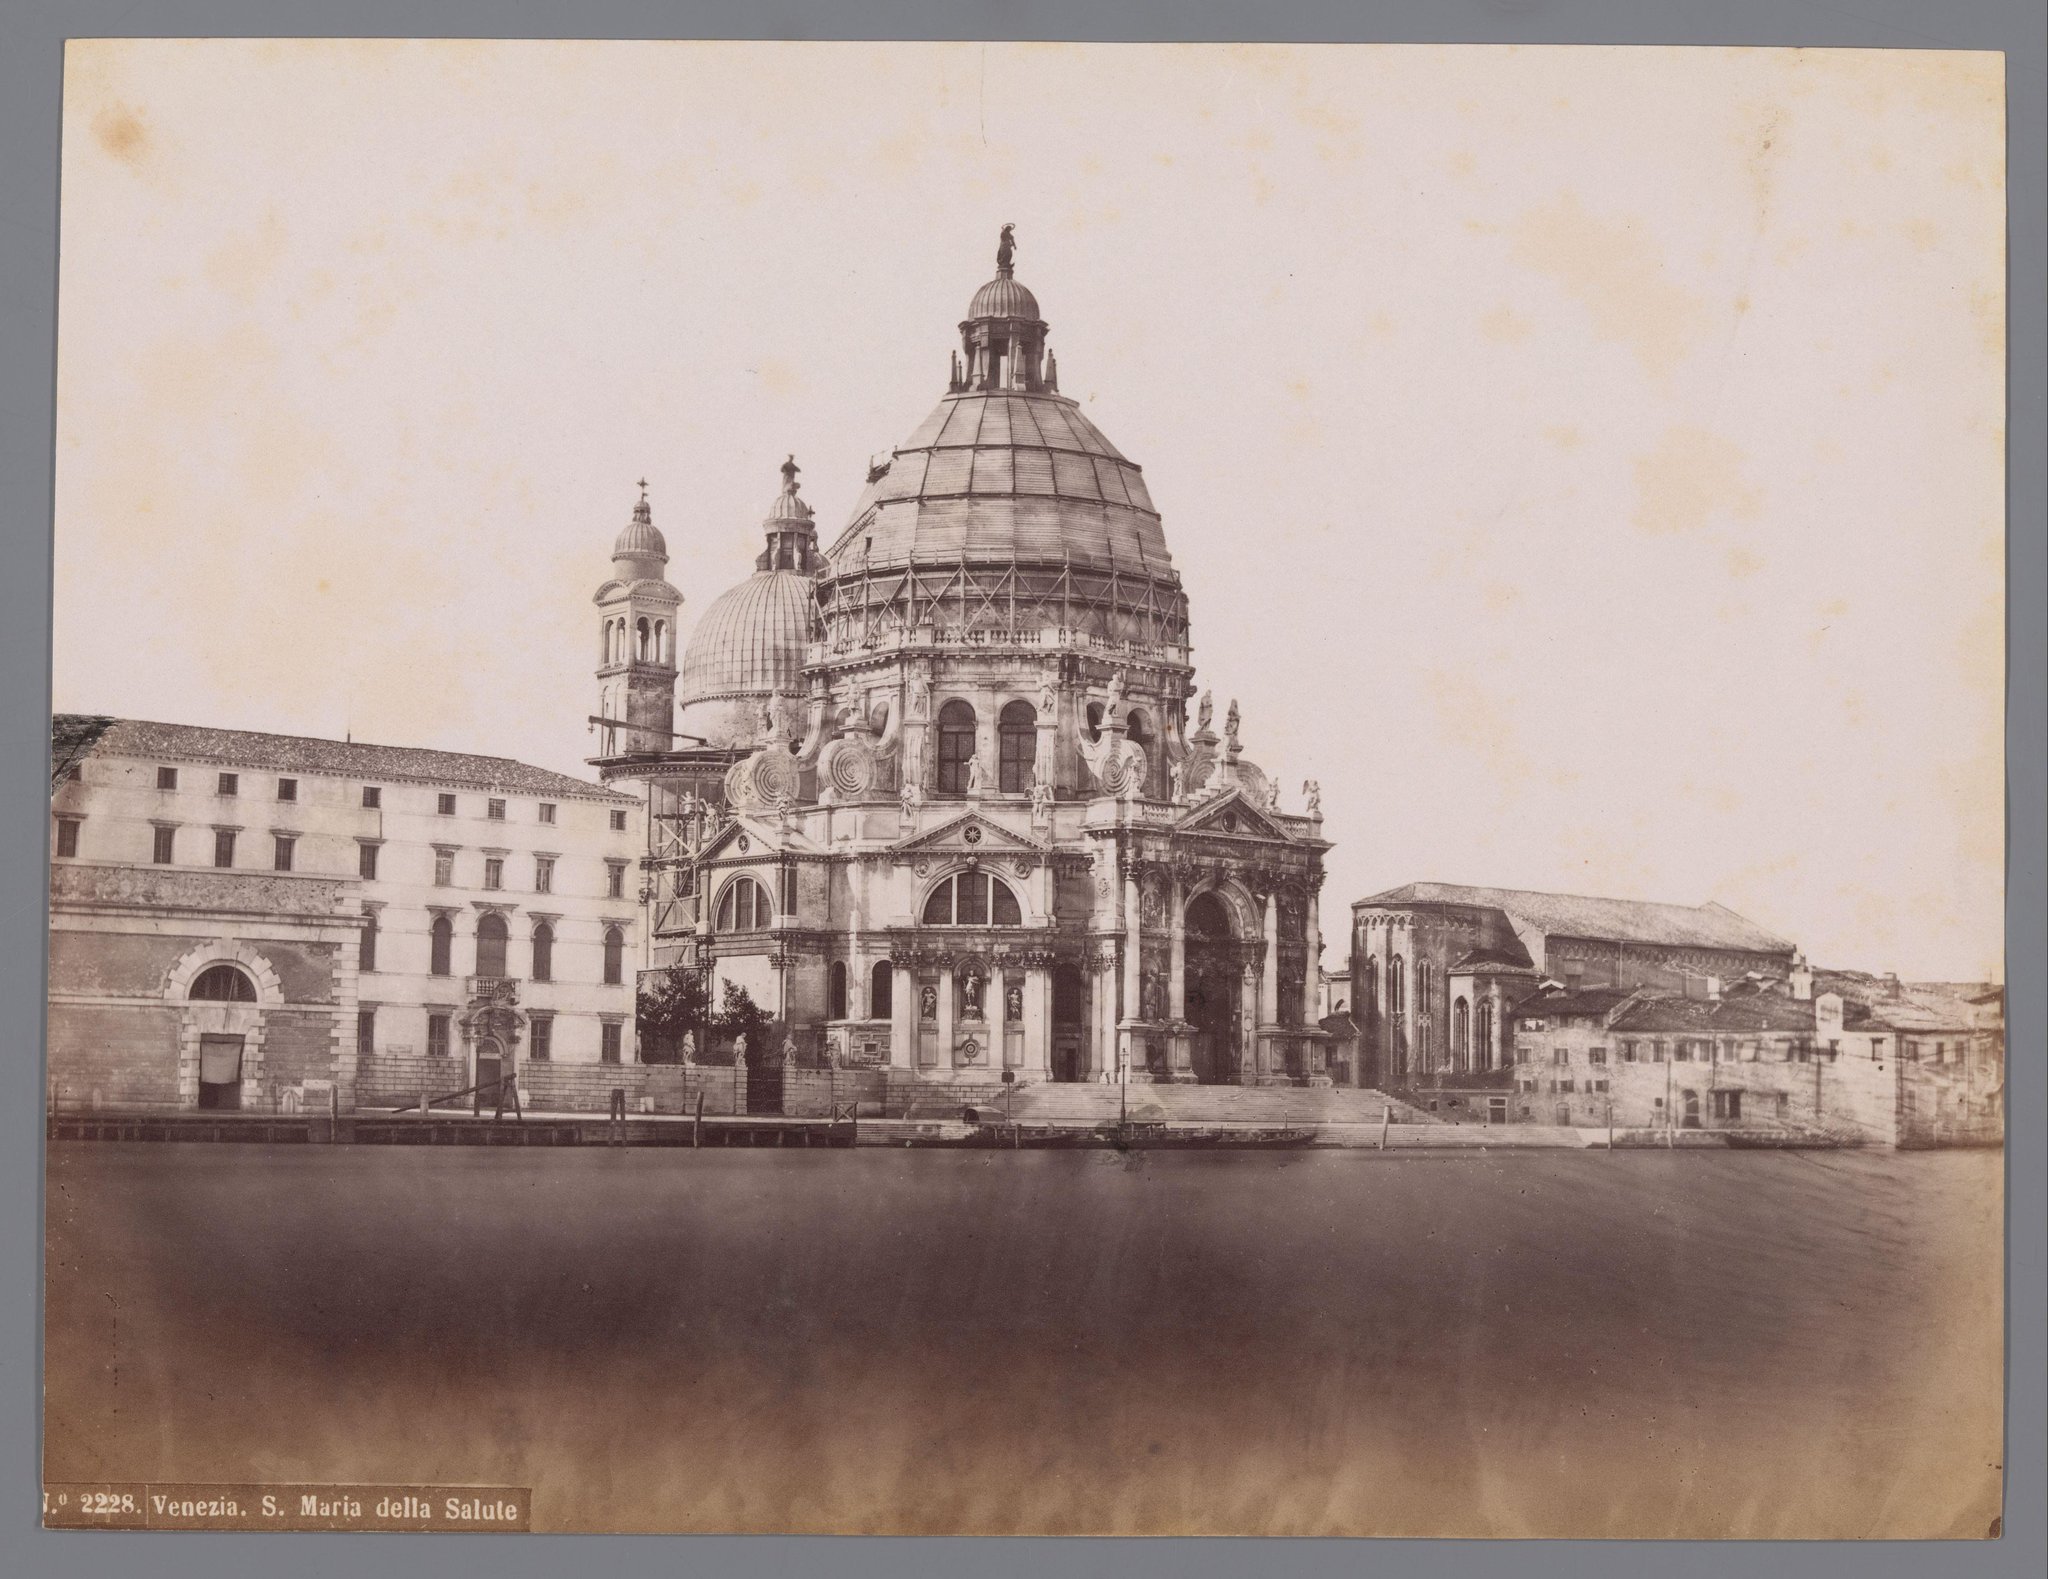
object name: photograph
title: Venezia. S. Maria della Salute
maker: Anonymous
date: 1851-1900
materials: paper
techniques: albumen print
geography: venice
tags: church (exterior), canals, waters (in city), dome ~ architecture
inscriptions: number: ‘No. 2228.’